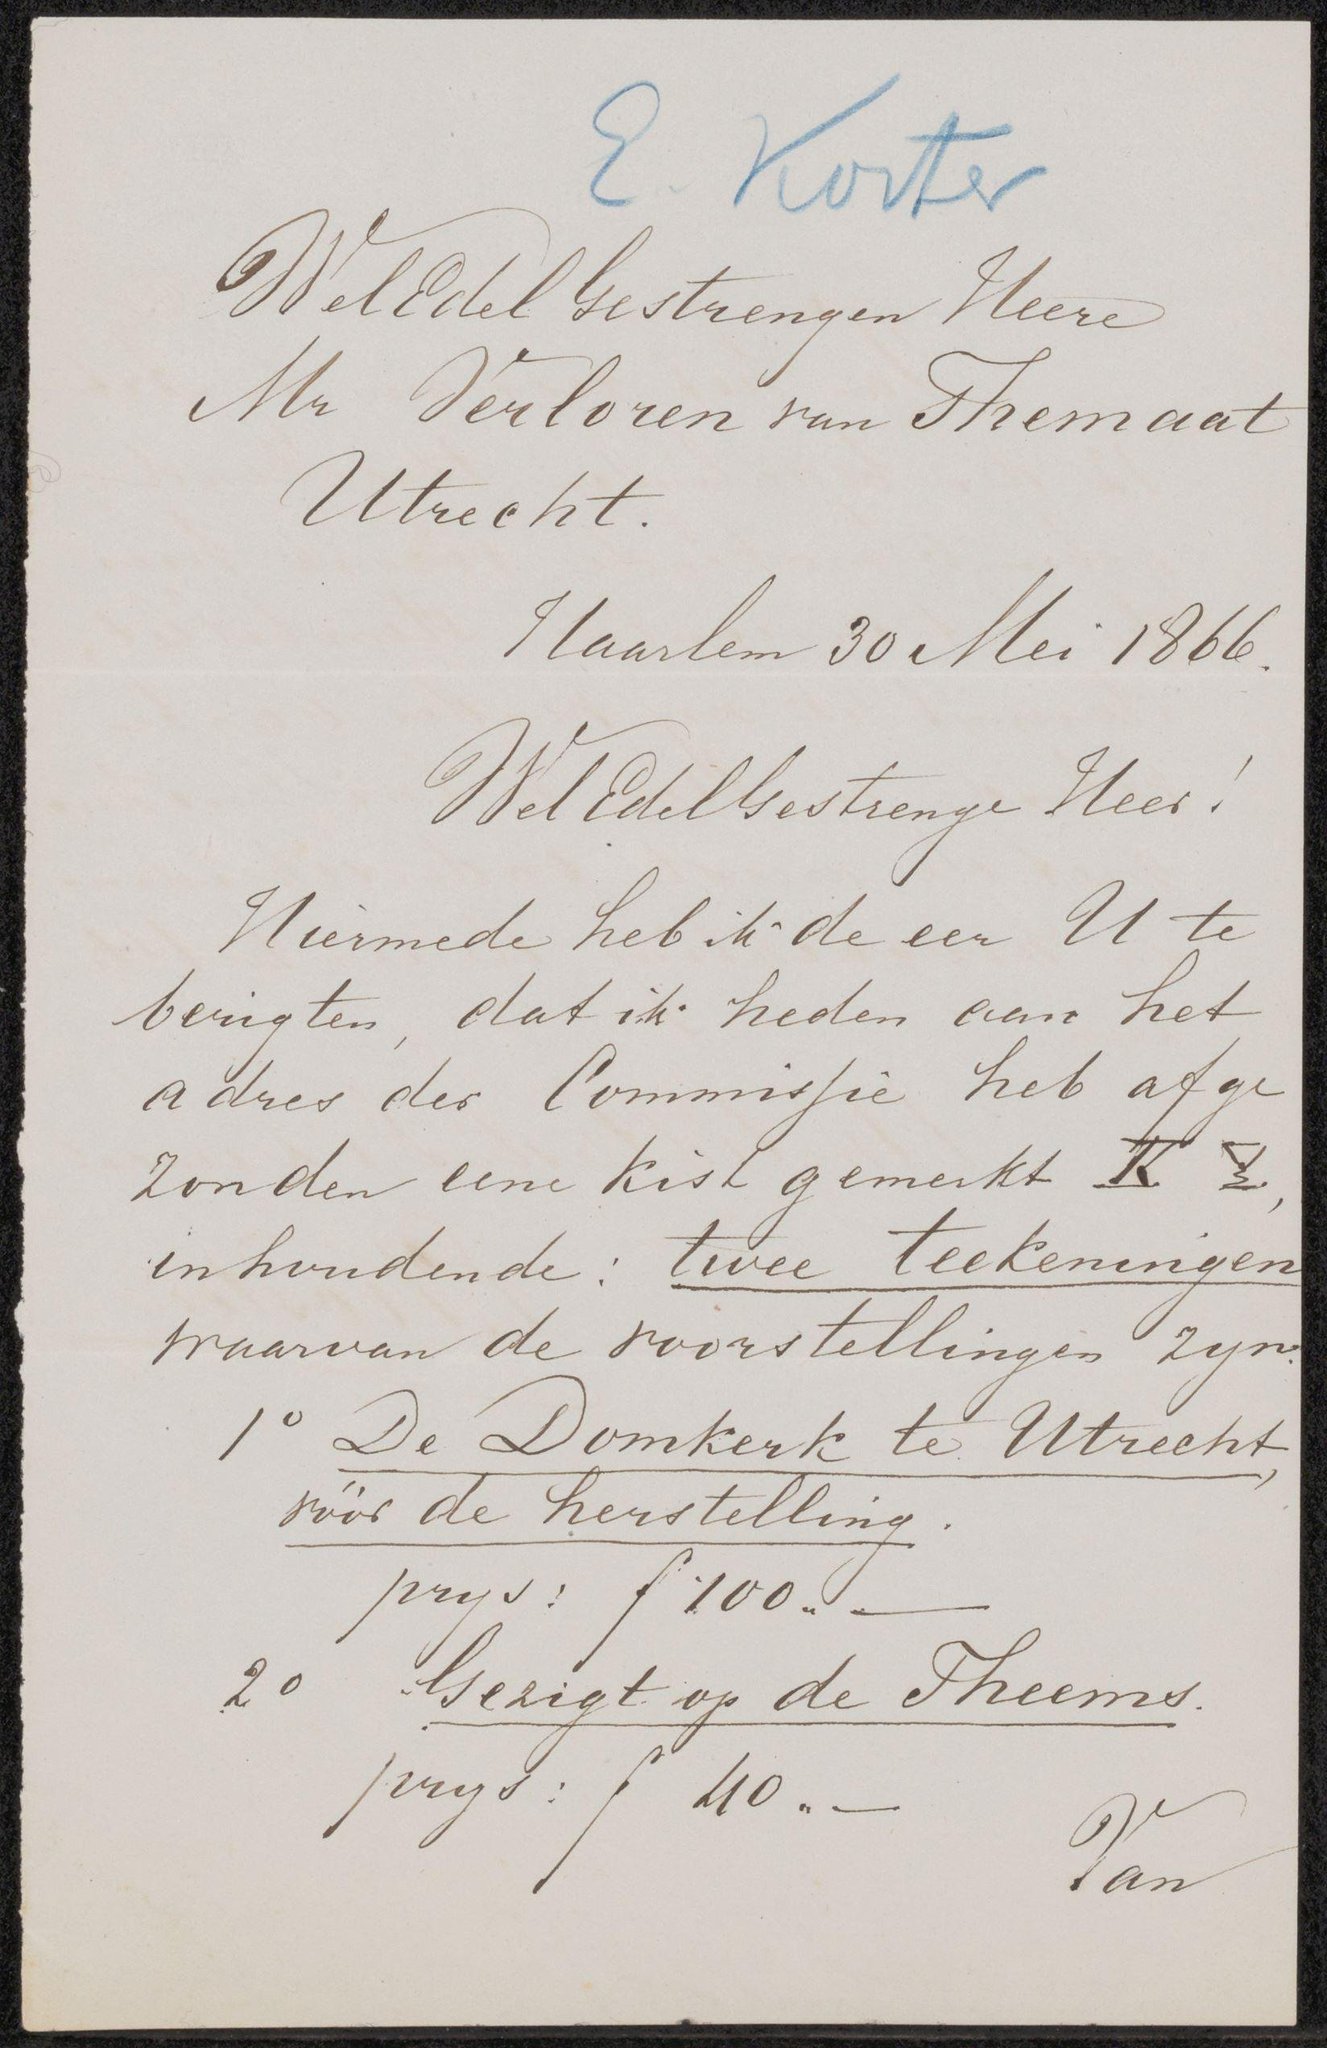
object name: letter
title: Brief aan Pieter Verloren van Themaat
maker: everhardus koster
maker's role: draughtsman, painter, print maker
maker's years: 1817-1892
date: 1866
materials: ink, paper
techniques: pen, writing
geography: haarlem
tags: utrecht, pieter verloren van themaat, drawing, exhibition ~ art, money